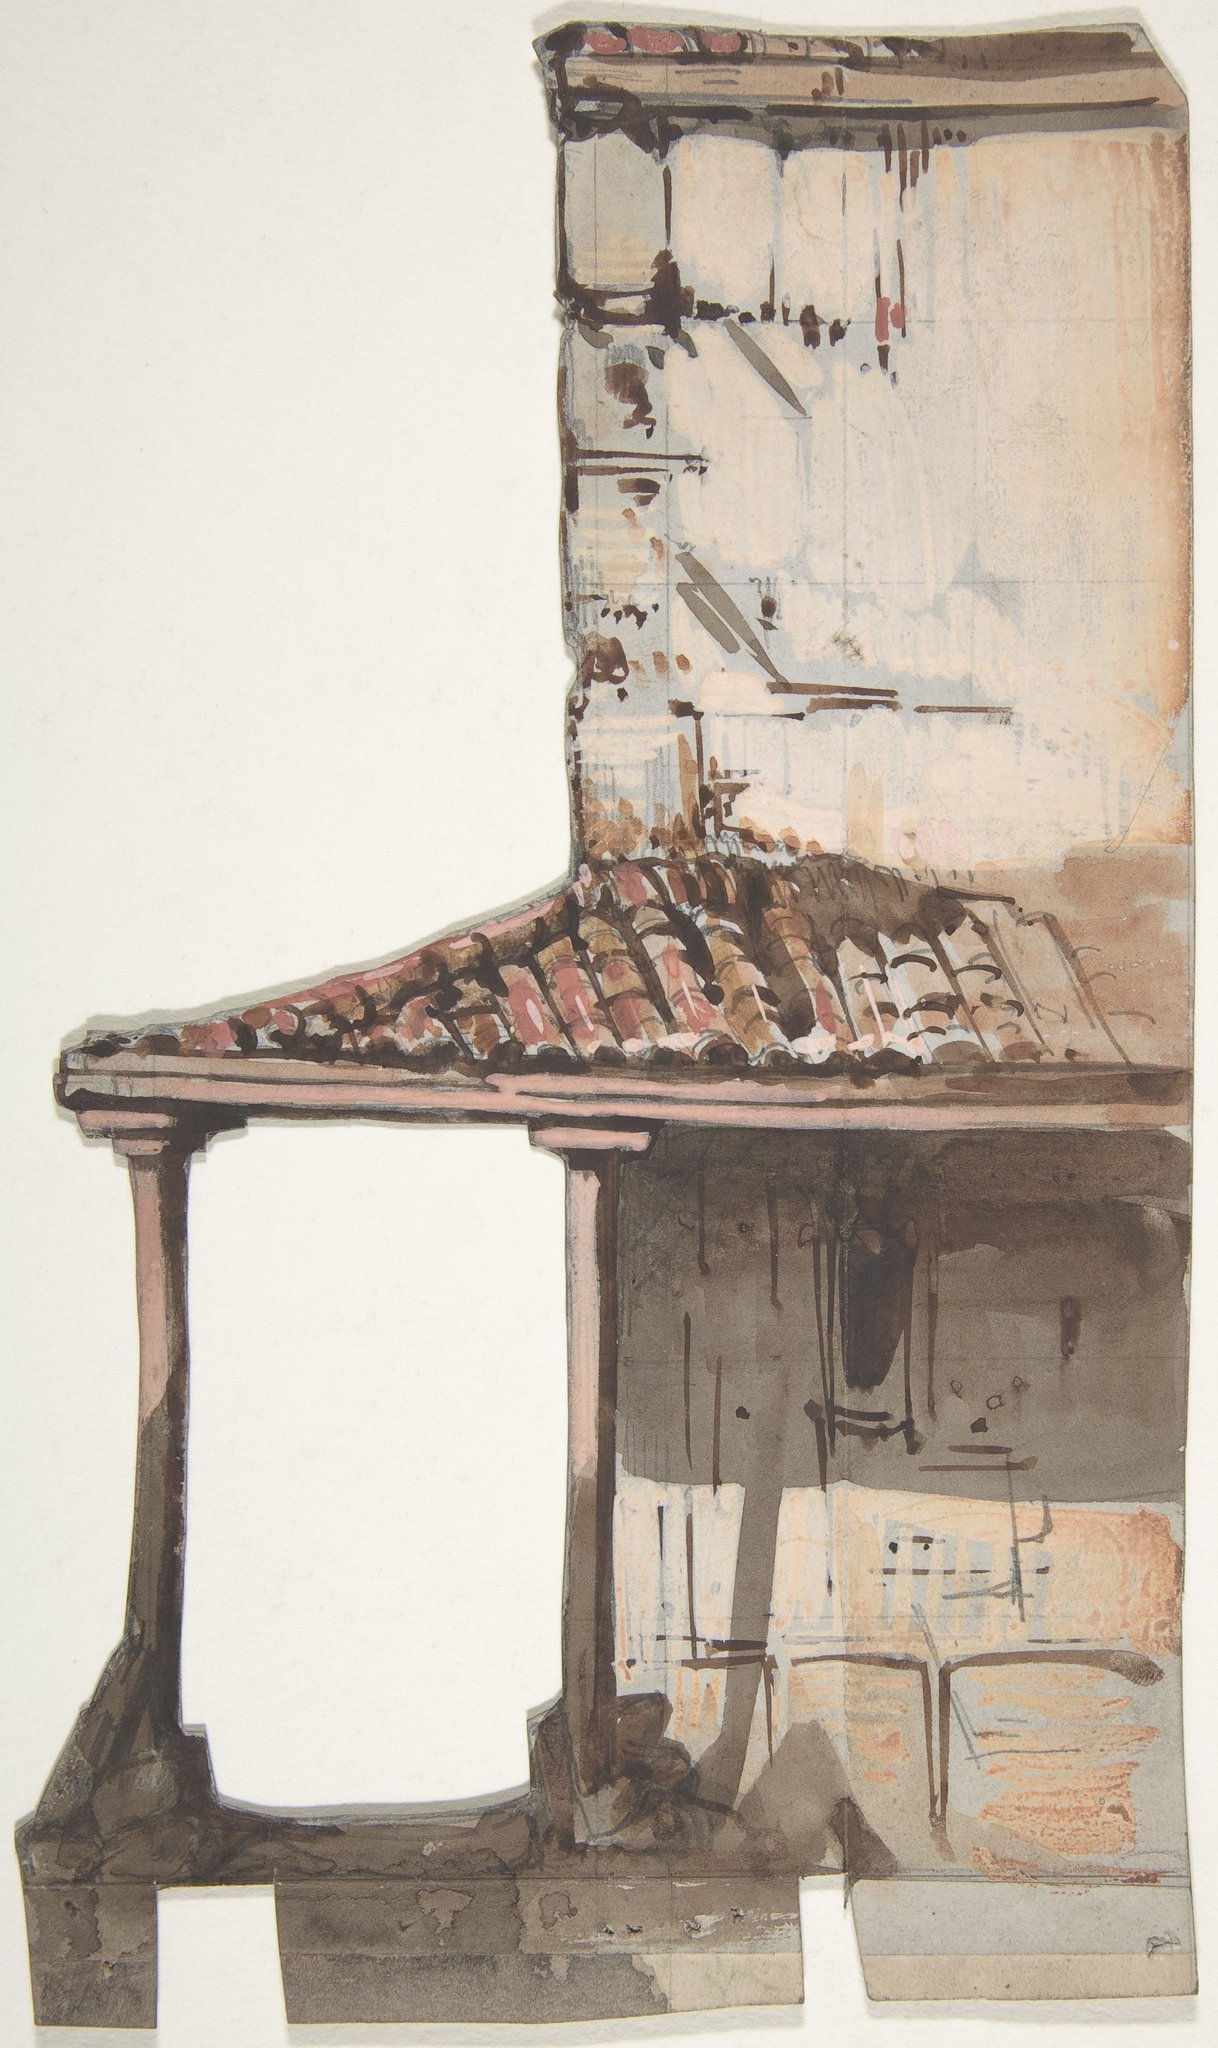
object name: drawing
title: Design for a Stage Set at the Opéra, Paris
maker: eugène cicéri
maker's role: artist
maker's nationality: french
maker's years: 1813-1890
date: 1830-1890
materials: gouache, graphite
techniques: brush, wash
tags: stage design